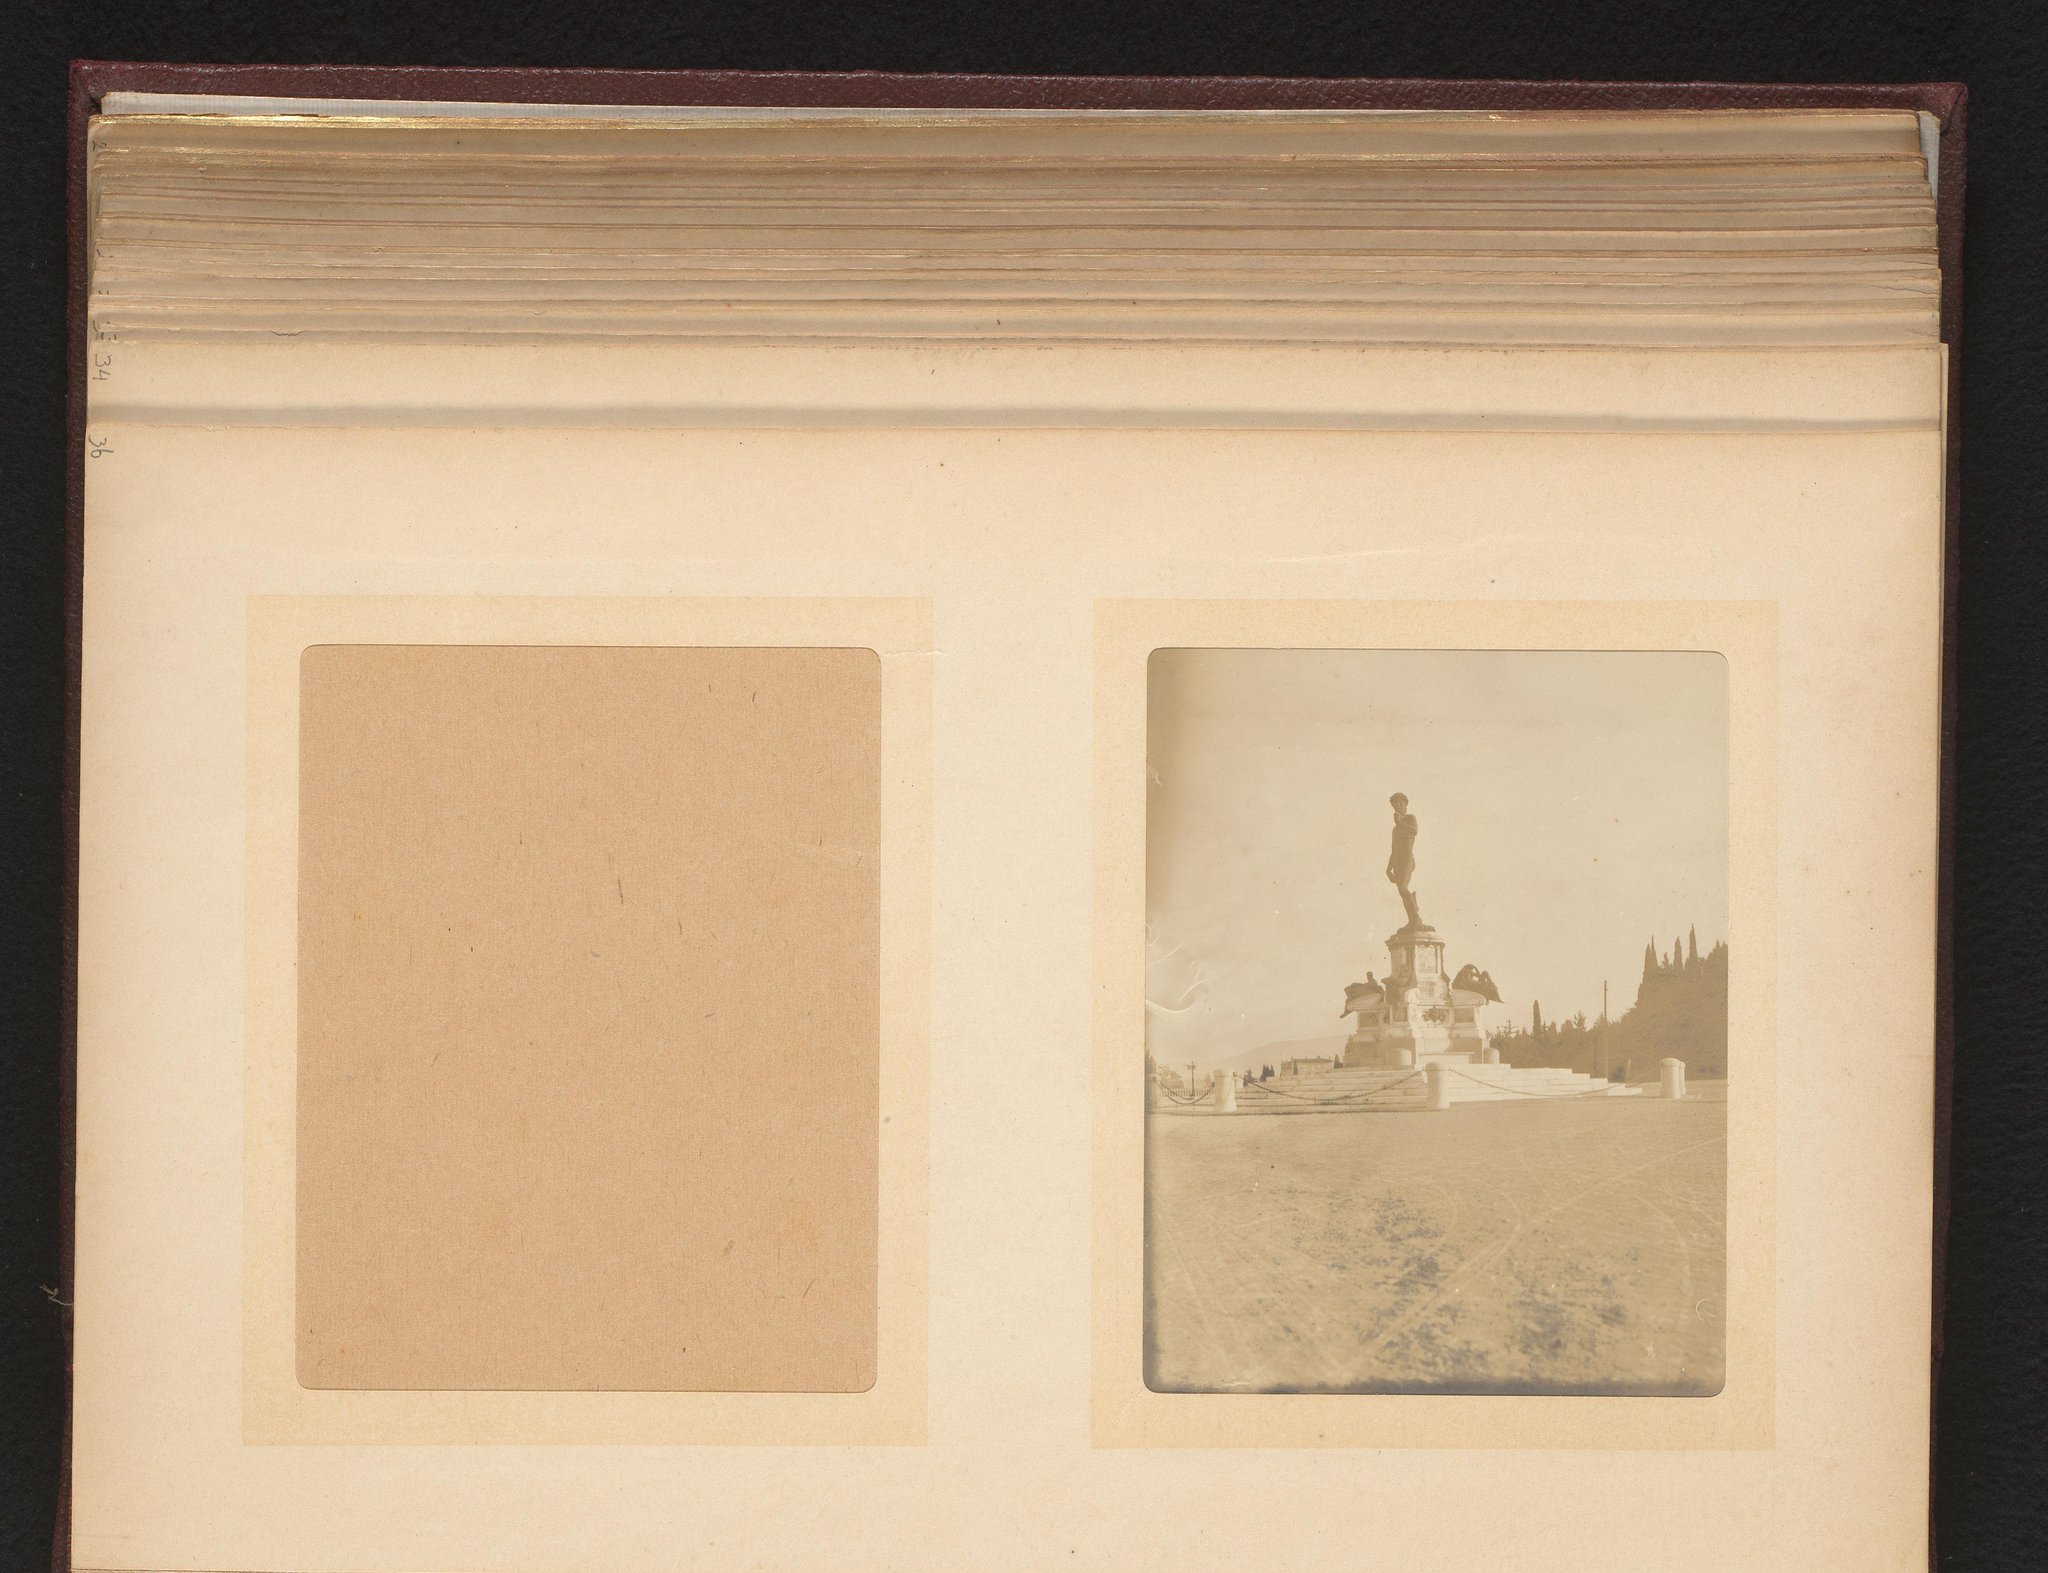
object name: photograph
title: Piazzale Michelangelo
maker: Anonymous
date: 1895-1905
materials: cardboard, photographic support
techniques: gelatin silver print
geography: florence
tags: tourism, monument, statue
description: Albumblad met een foto te Florence, en een leeg vakje. Onderdeel van een fotoalbum van een reis door Italië, ca. 1900.